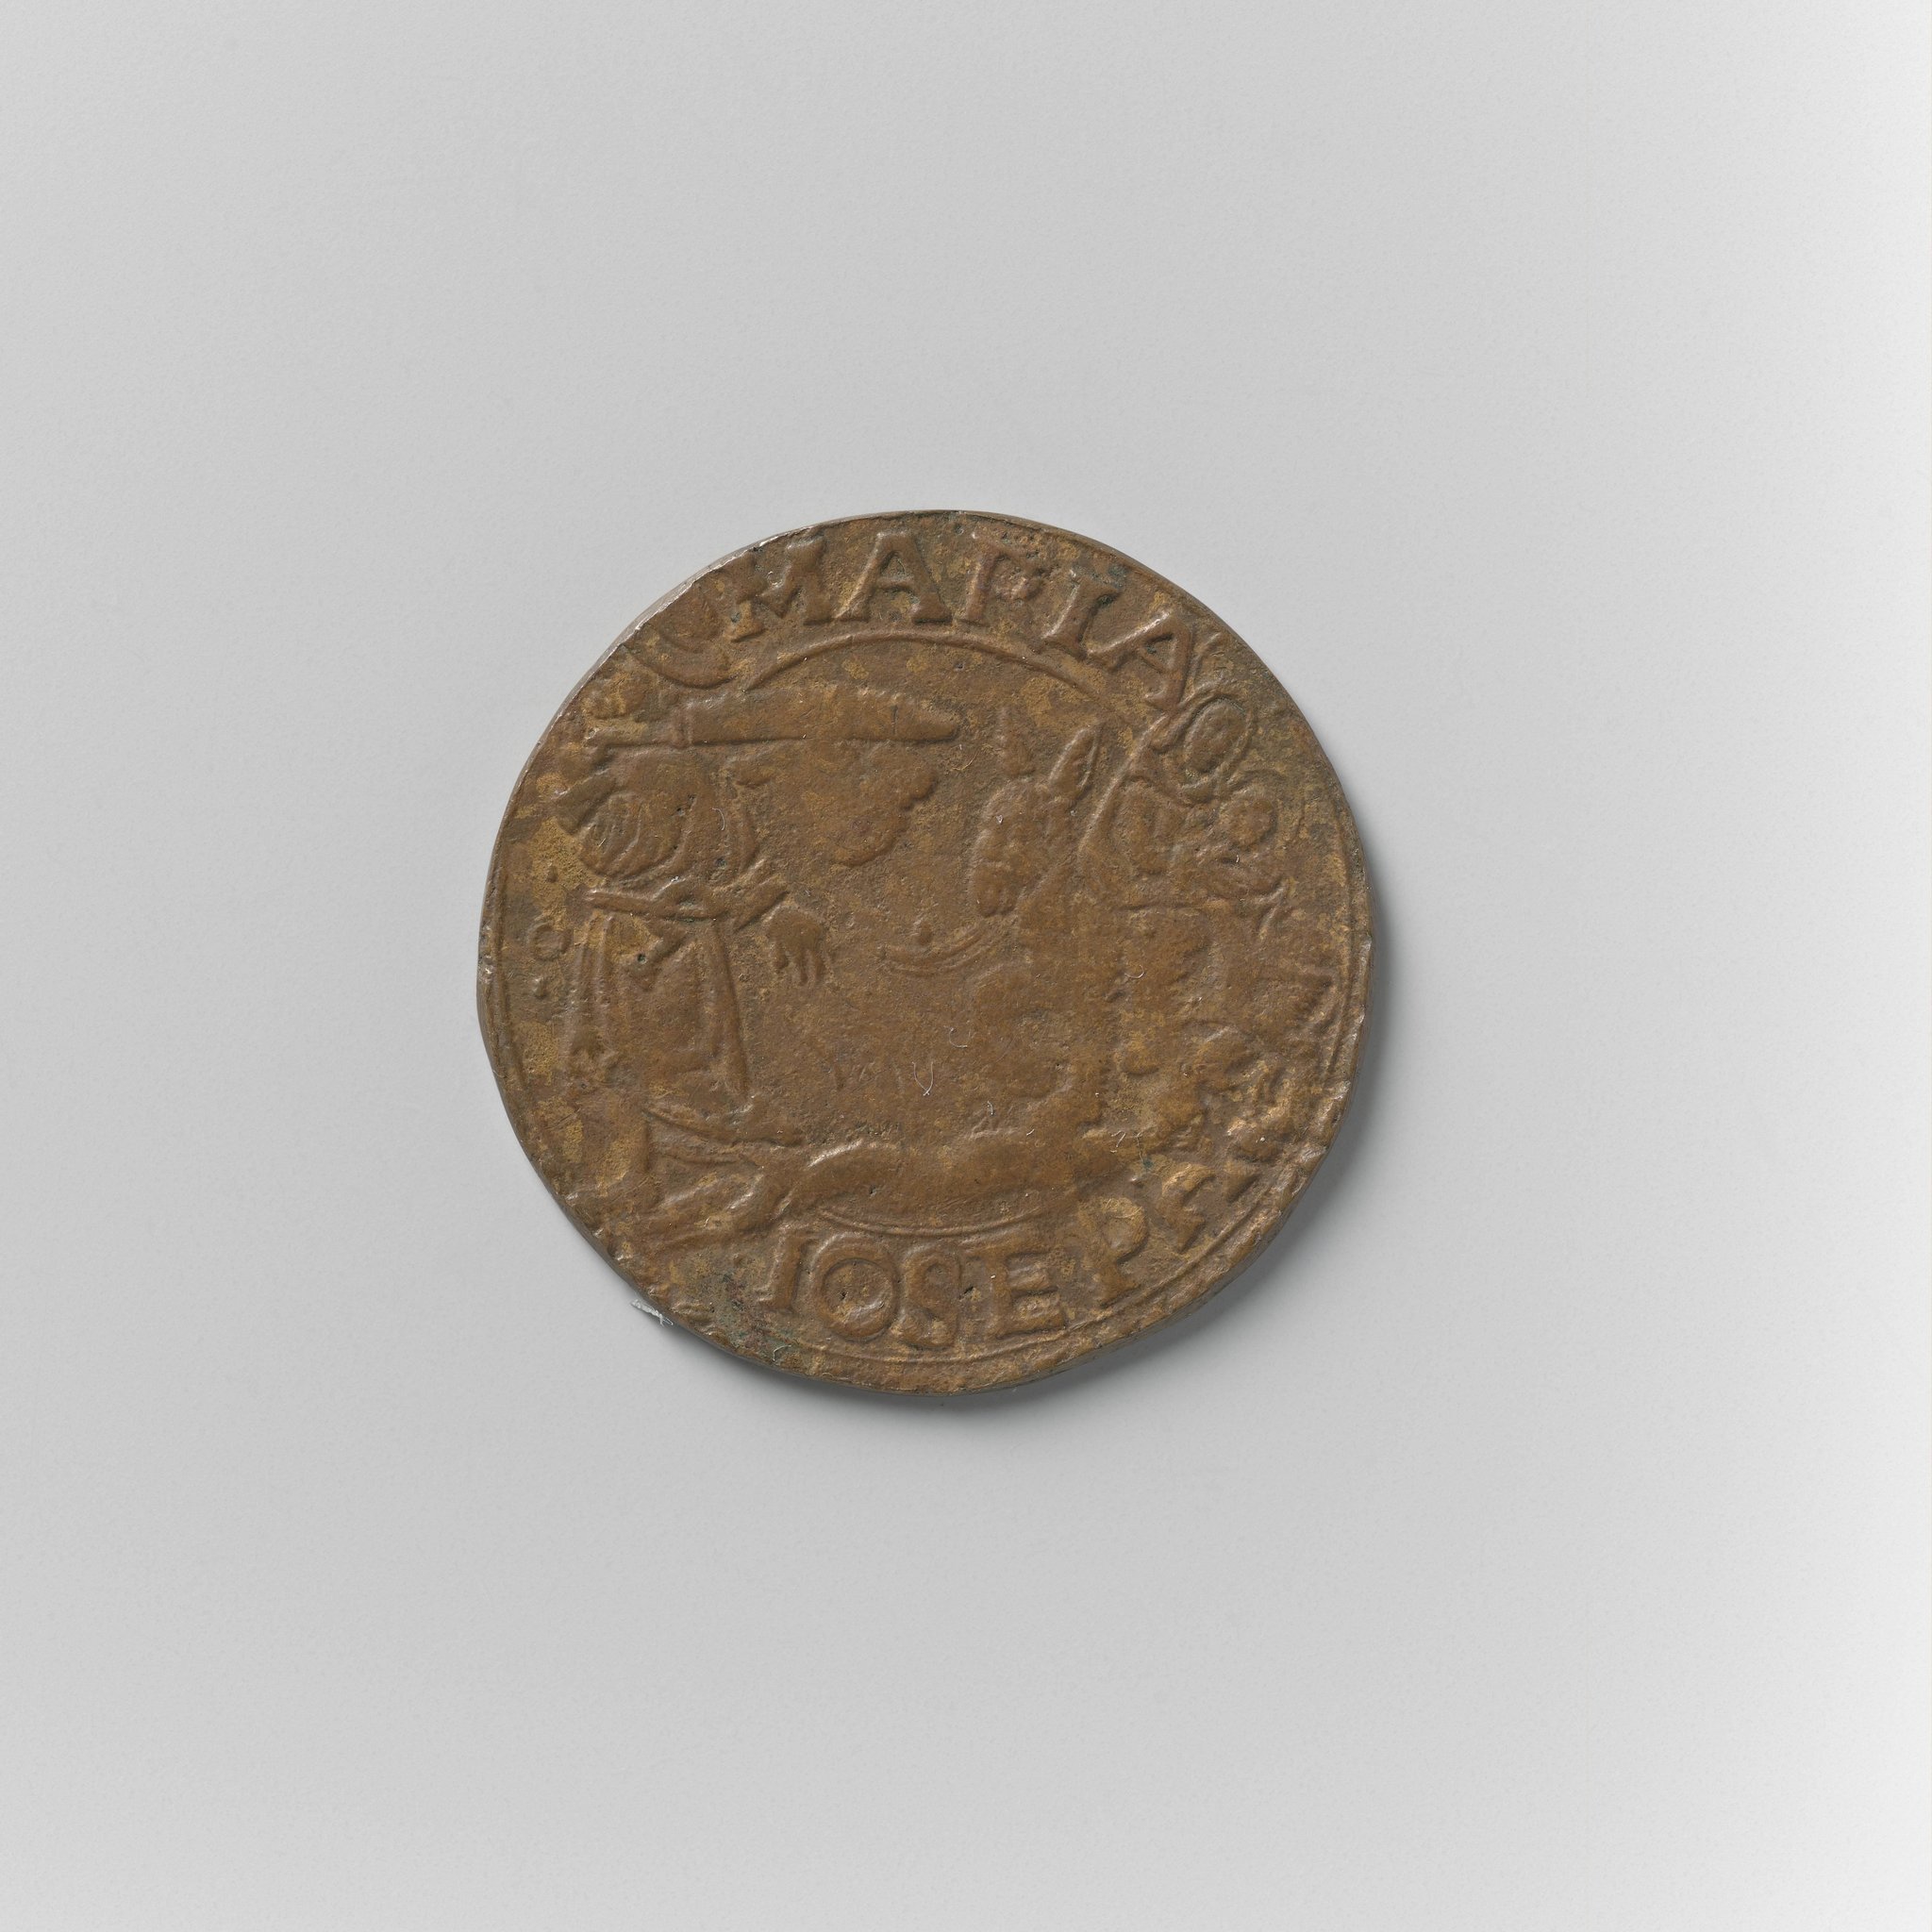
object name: medal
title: Timmerliedengilde van onbekende plaats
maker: Anonymous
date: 1549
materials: copper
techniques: striking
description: Koperen penning. Voorzijde: Maria, zittend met kind op ezeltje, dat door Jozef geleid wordt binnen omschrift. Keerzijde: timmermansgereedschap; daartussen jaartal